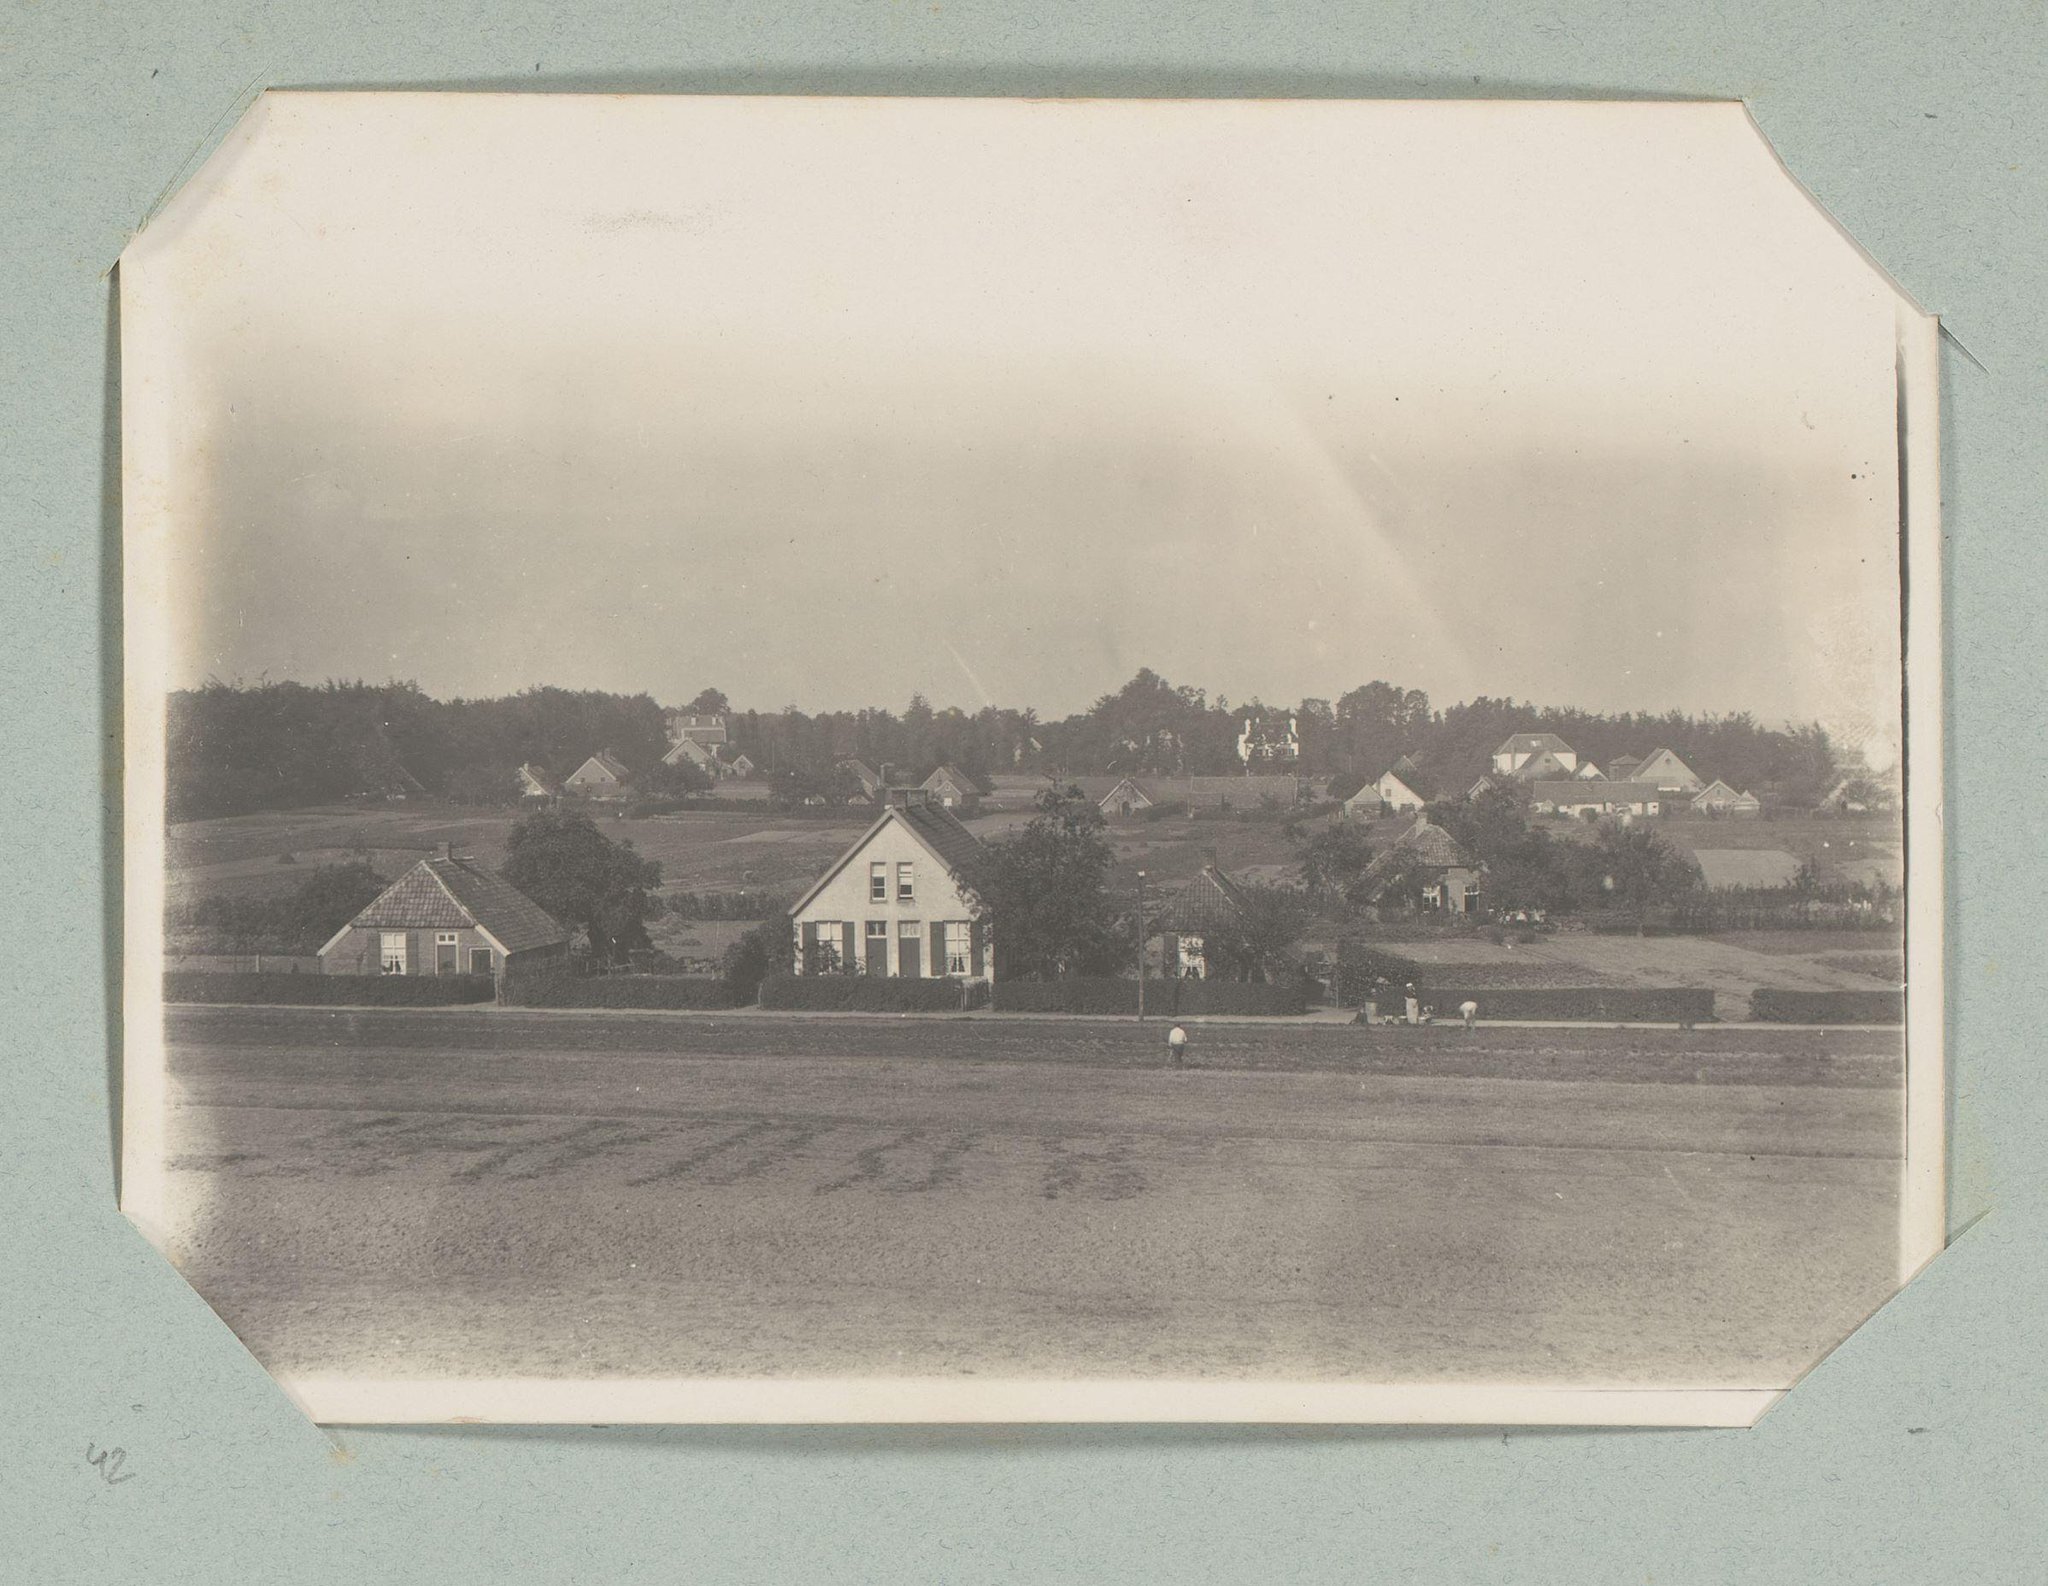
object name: album leaf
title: Gezicht op Oosterbeek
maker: Anonymous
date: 1907-1909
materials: paper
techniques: gelatin silver print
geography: netherlands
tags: prospect of village, silhouette of village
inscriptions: inscription: ‘Herinnering aan Sept. 1907./ Oosterbeek (Hoog)’